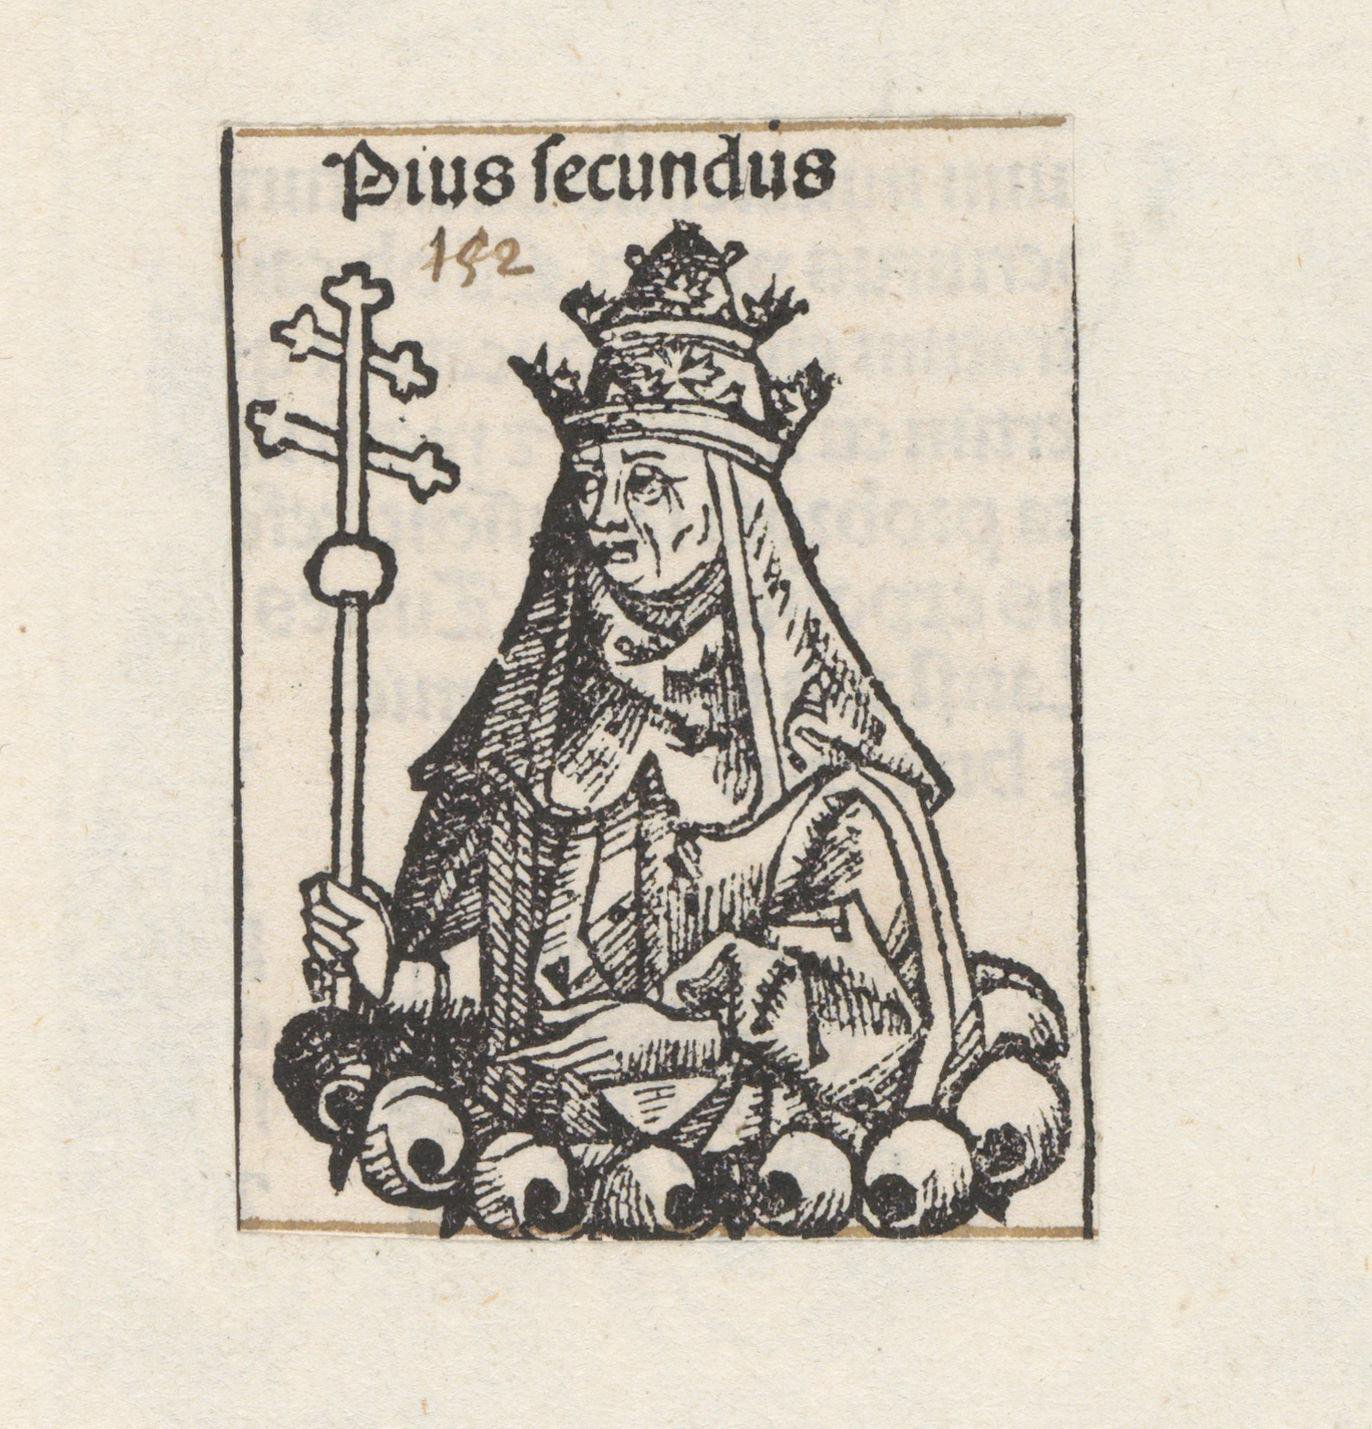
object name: album leaf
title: Paus Pius II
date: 1493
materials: paper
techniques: letterpress printing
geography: nuremberg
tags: rome, pope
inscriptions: inscription: ‘152’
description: Een bloemkelk met een paus. Hij draagt een tiara en heeft een staf met dubbel kruis in zijn handen. De voorstelling is onderdeel van de opeenvolging pausen in de Liber Chronicarum. De tekst identificeert de man als Pius II. De prent maakt deel uit van een album.